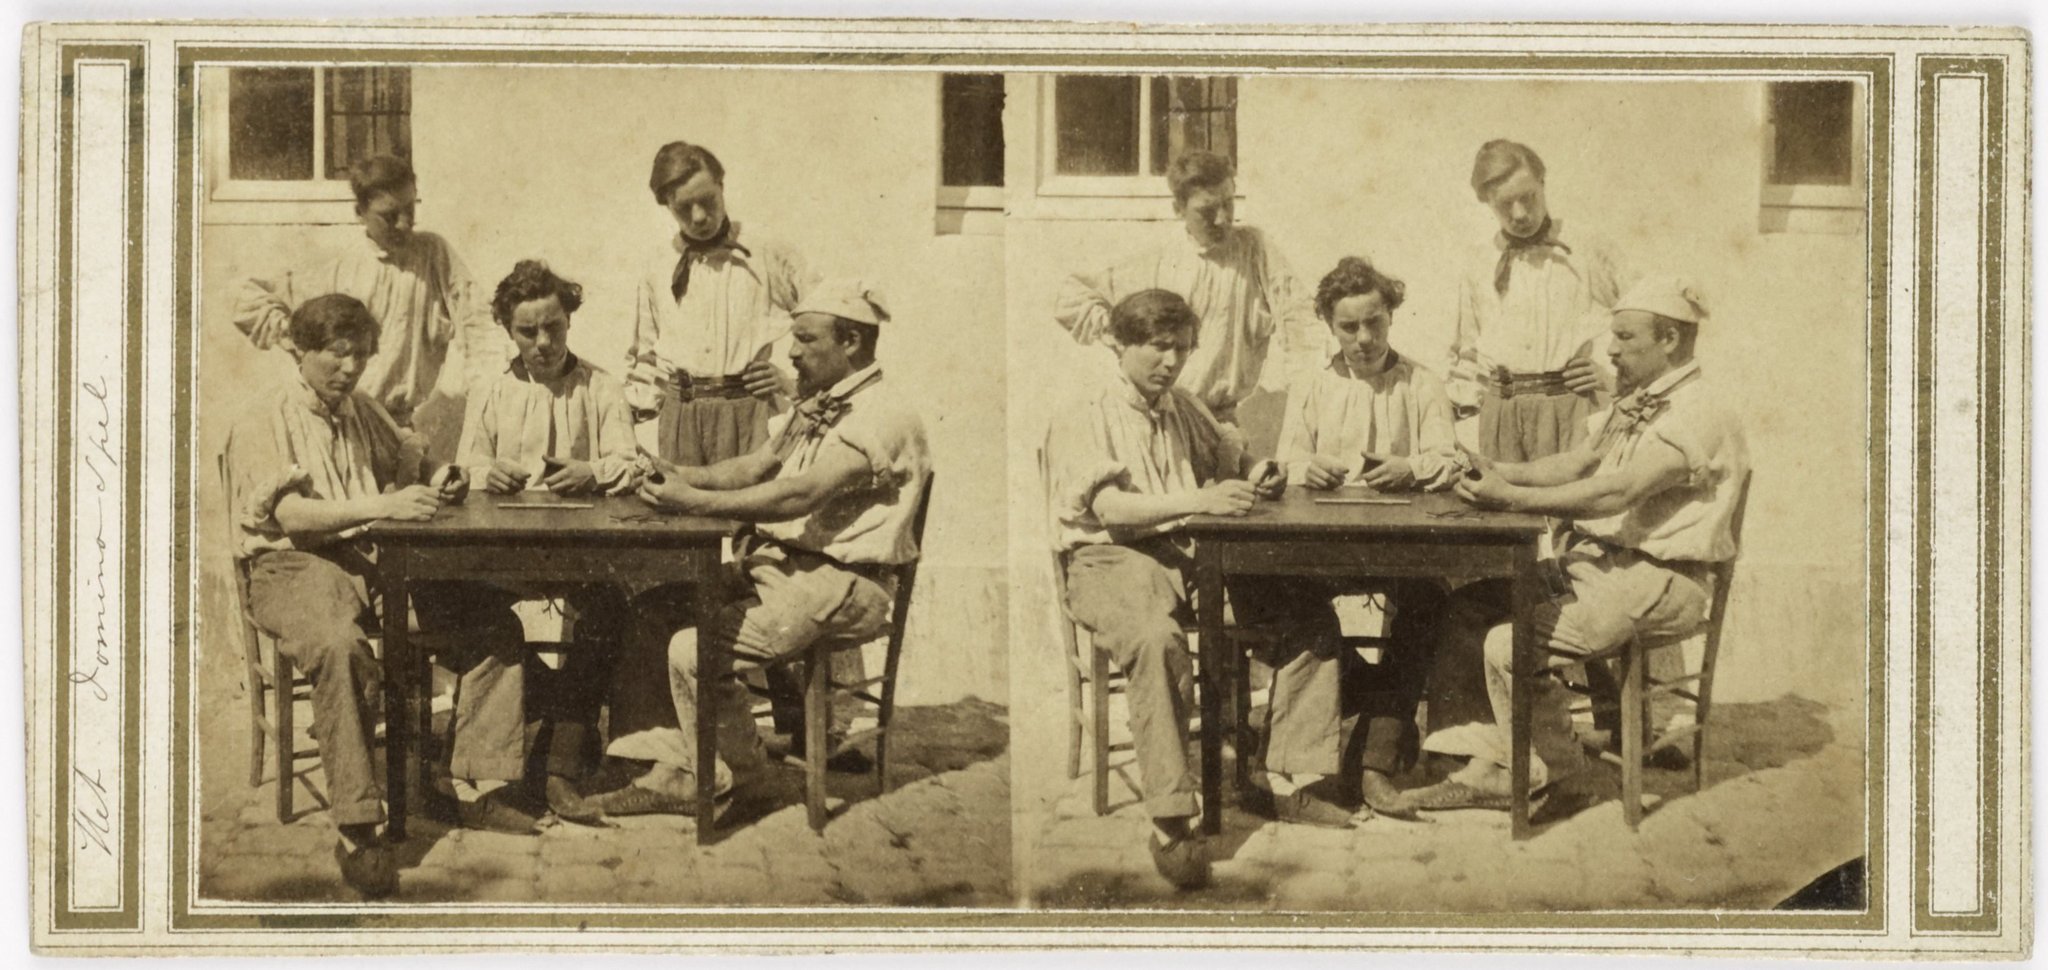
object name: stereograph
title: Mannen die aan een tafel domino spelen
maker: pierre-ambroise richebourg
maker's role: fotograaf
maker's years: 1810-1875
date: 1850-1880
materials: cardboard, photographic support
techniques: albumen print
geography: europe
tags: dominoes, europe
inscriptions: inscription: ‘Het dominospel.’